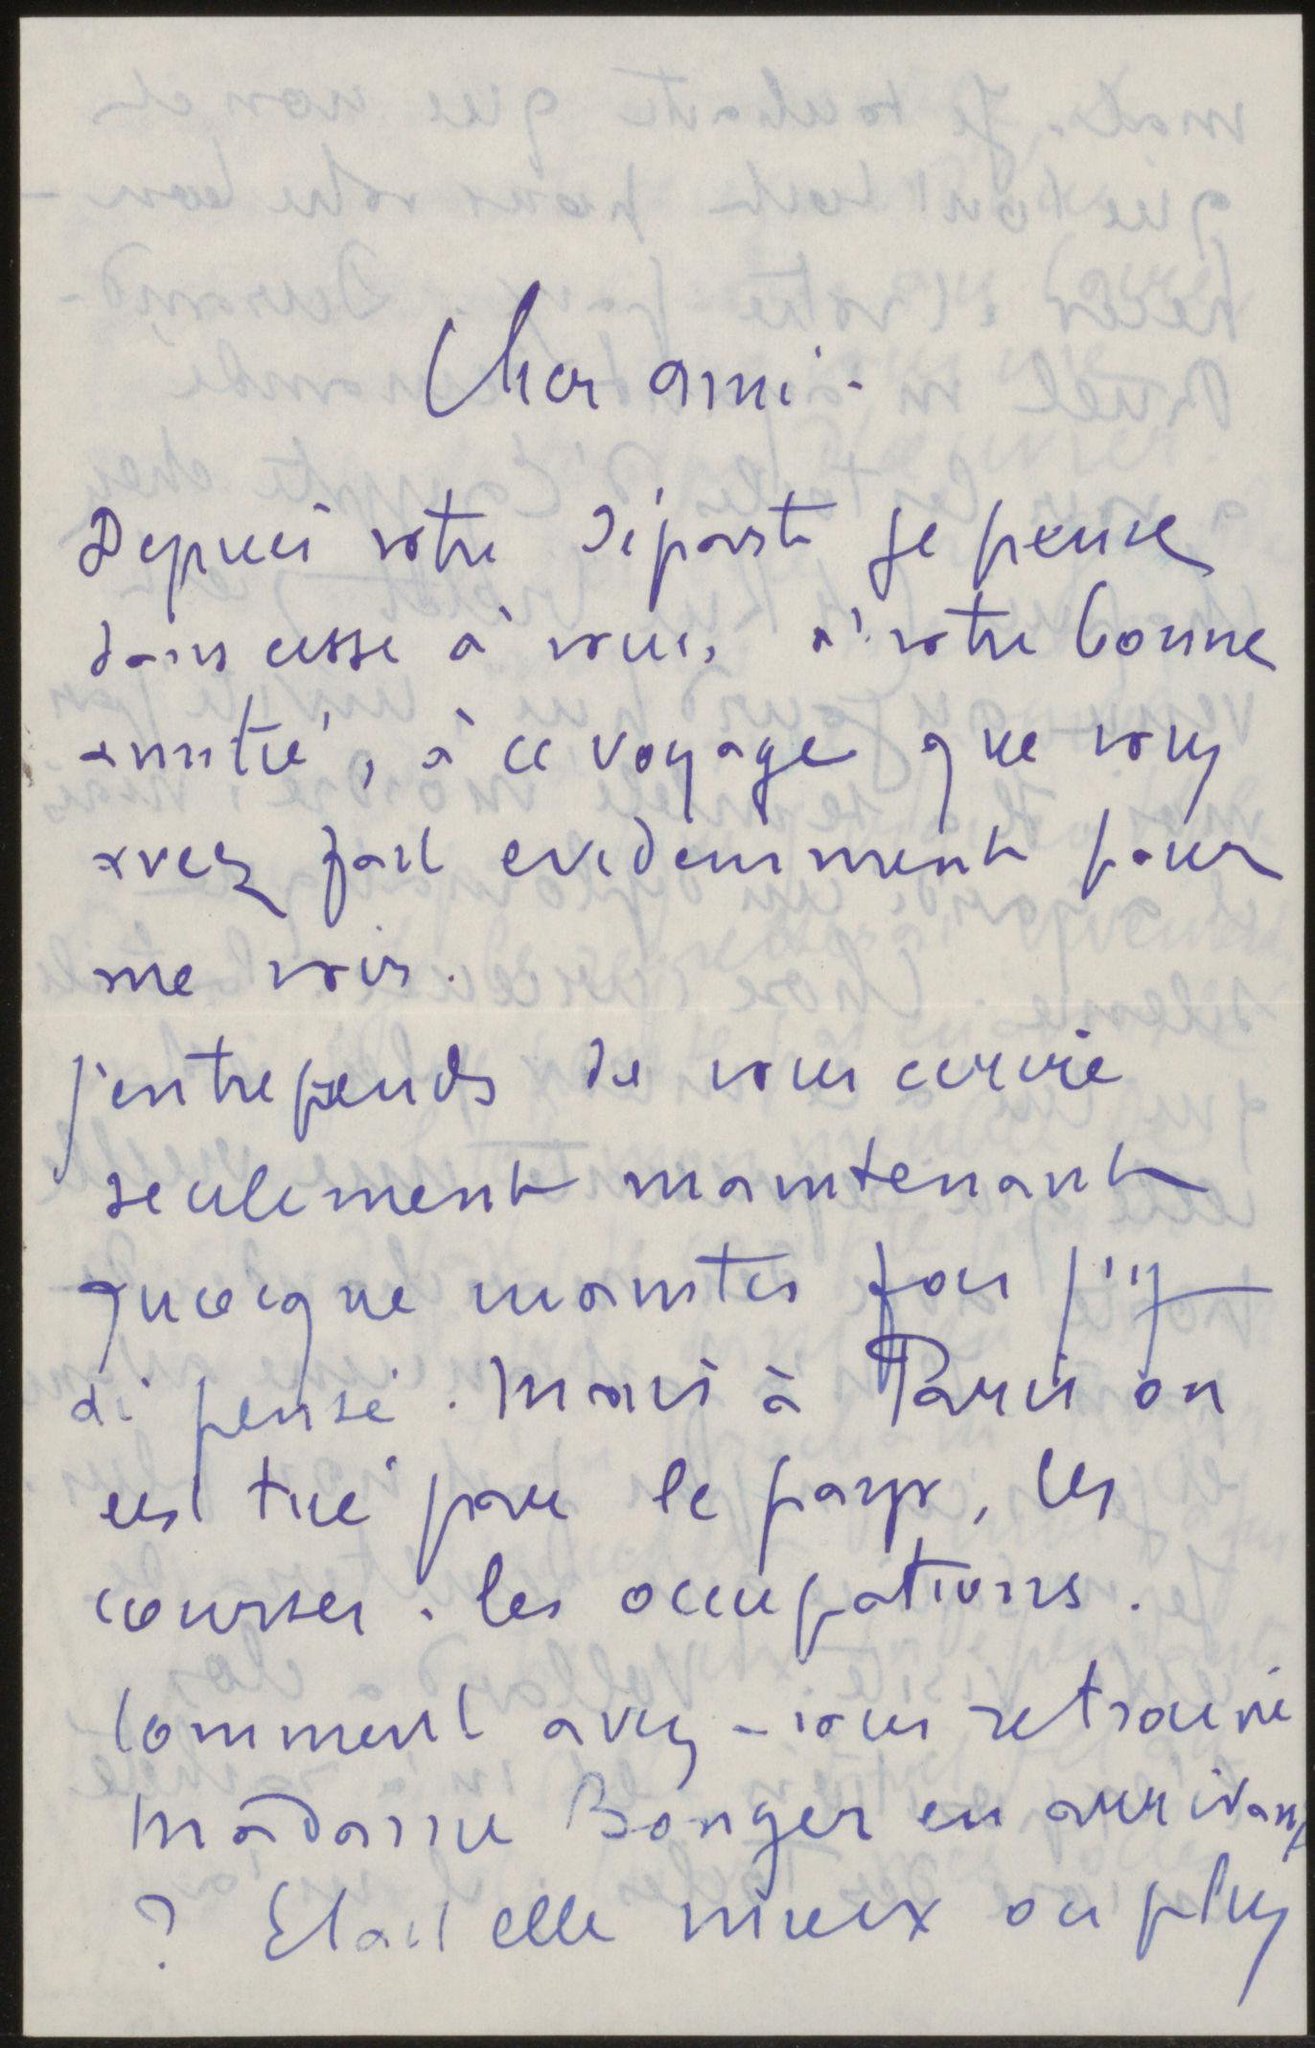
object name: letter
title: Brief aan Andries Bonger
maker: émile bernard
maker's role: print maker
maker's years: 1868-1941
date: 1901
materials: ink, paper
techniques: pen, writing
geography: colombes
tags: odilon redon, paris, painter, claude monet, berthe morisot, paul cézanne, sculptor, edgar degas, print maker, draughtsman, camille jacob pissarro, amsterdam, andries bonger, roger marx, publisher, henri louis ambroise vollard, alfred sisley, paul durand-ruel, family life, painting (including book-illumination, miniature-painting), historical persons (portraits and scenes from the life)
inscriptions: watermark